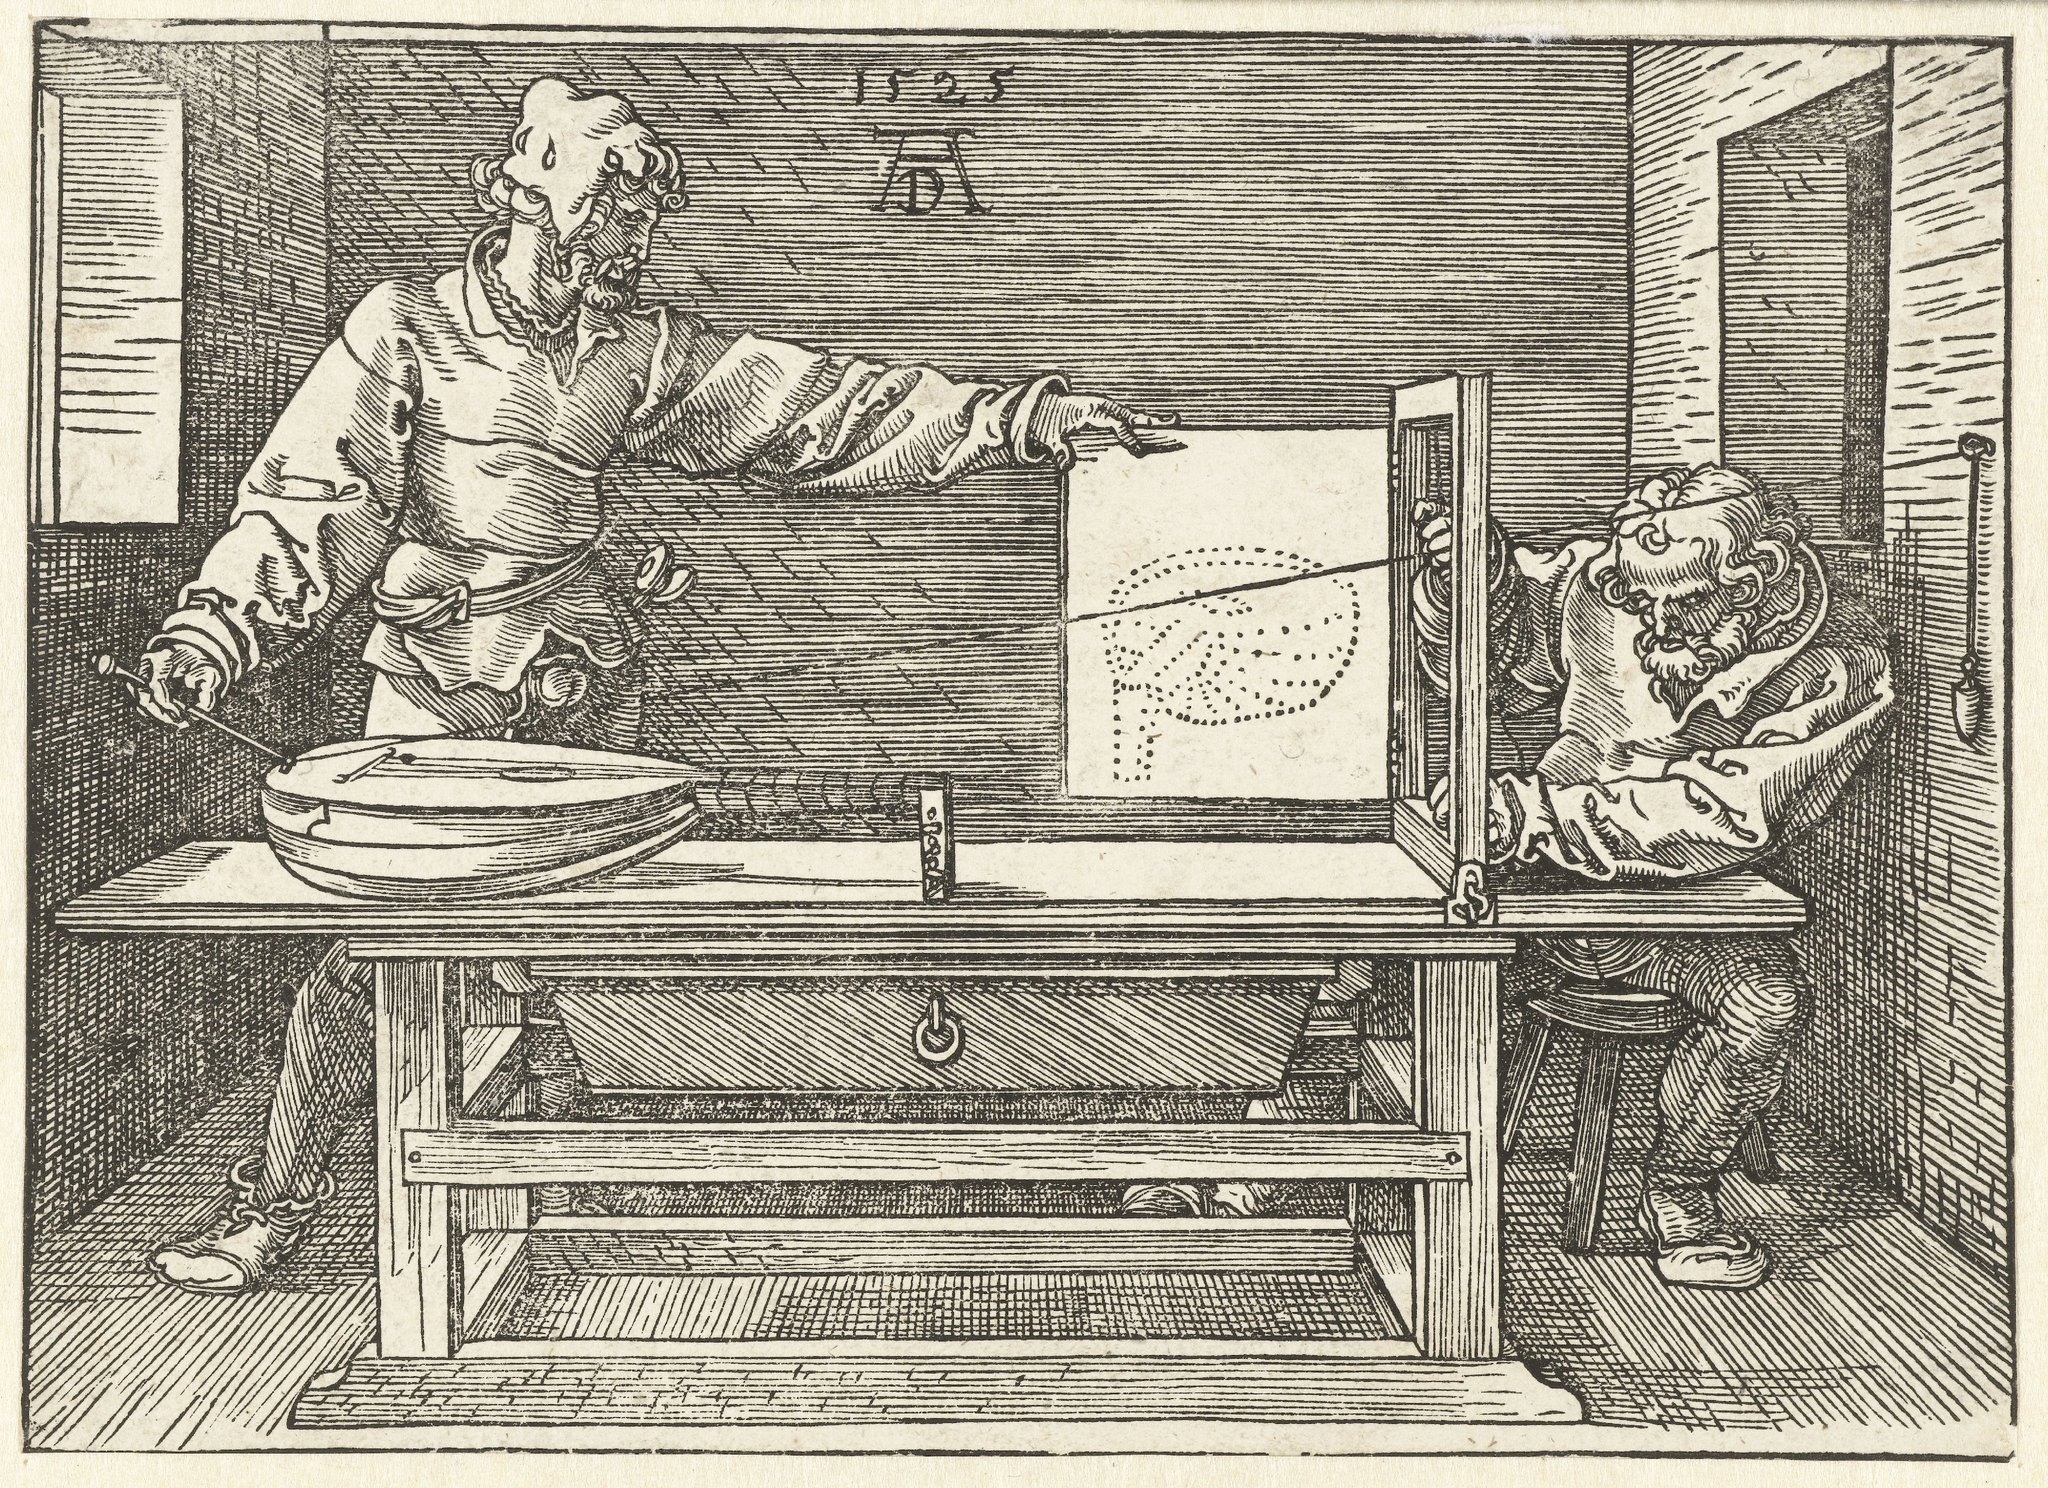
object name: print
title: Tekenaar tekent een luit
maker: albrecht dürer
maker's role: draughtsman, painter, print maker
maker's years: 1471-1528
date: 1525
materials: paper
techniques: woodcut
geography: nuremberg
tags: instruments for perspective drawing, draughtsman at work, lute, and special forms of lute, e.g.: theorbo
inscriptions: collector's mark: Lugt 240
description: De tekenaar en zijn helper werken volgens een door Dürer bedachte ingenieuze maar zeer omslachtige methode om de luit in verkort perspectief weer te geven